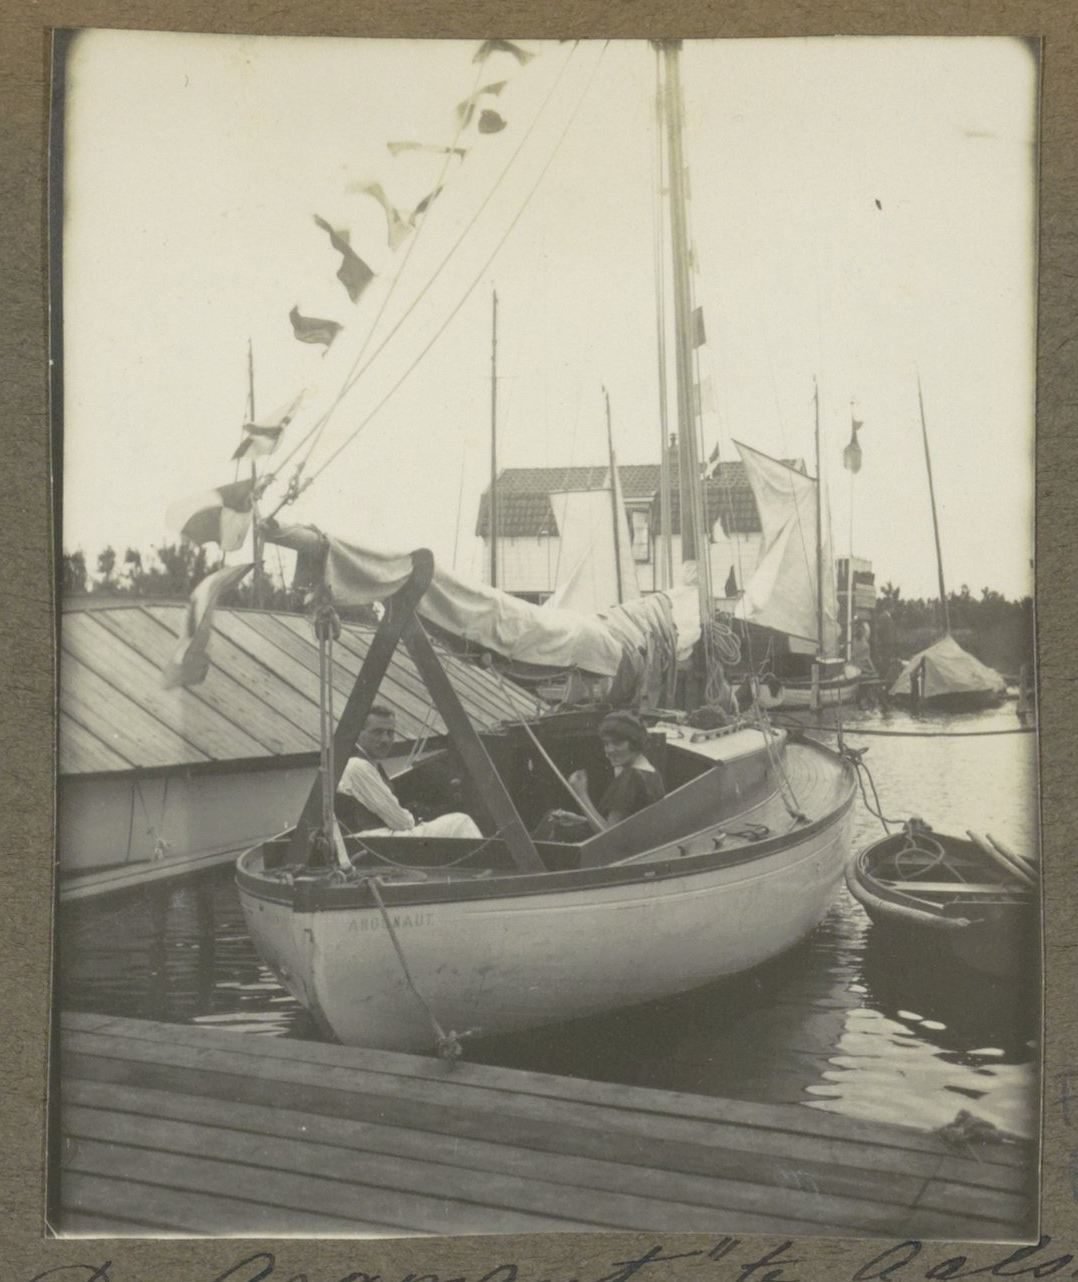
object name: photograph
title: De „Argonaut" te Aalsmeer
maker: Anonymous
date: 1920-1930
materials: photographic support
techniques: gelatin silver print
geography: aalsmeer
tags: sailing-ship, sailing-boat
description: Onderdeel van fotoalbum van een onbekende Nederlandse familie met opnames van Suriname, Europa en Nederlands-Indië.